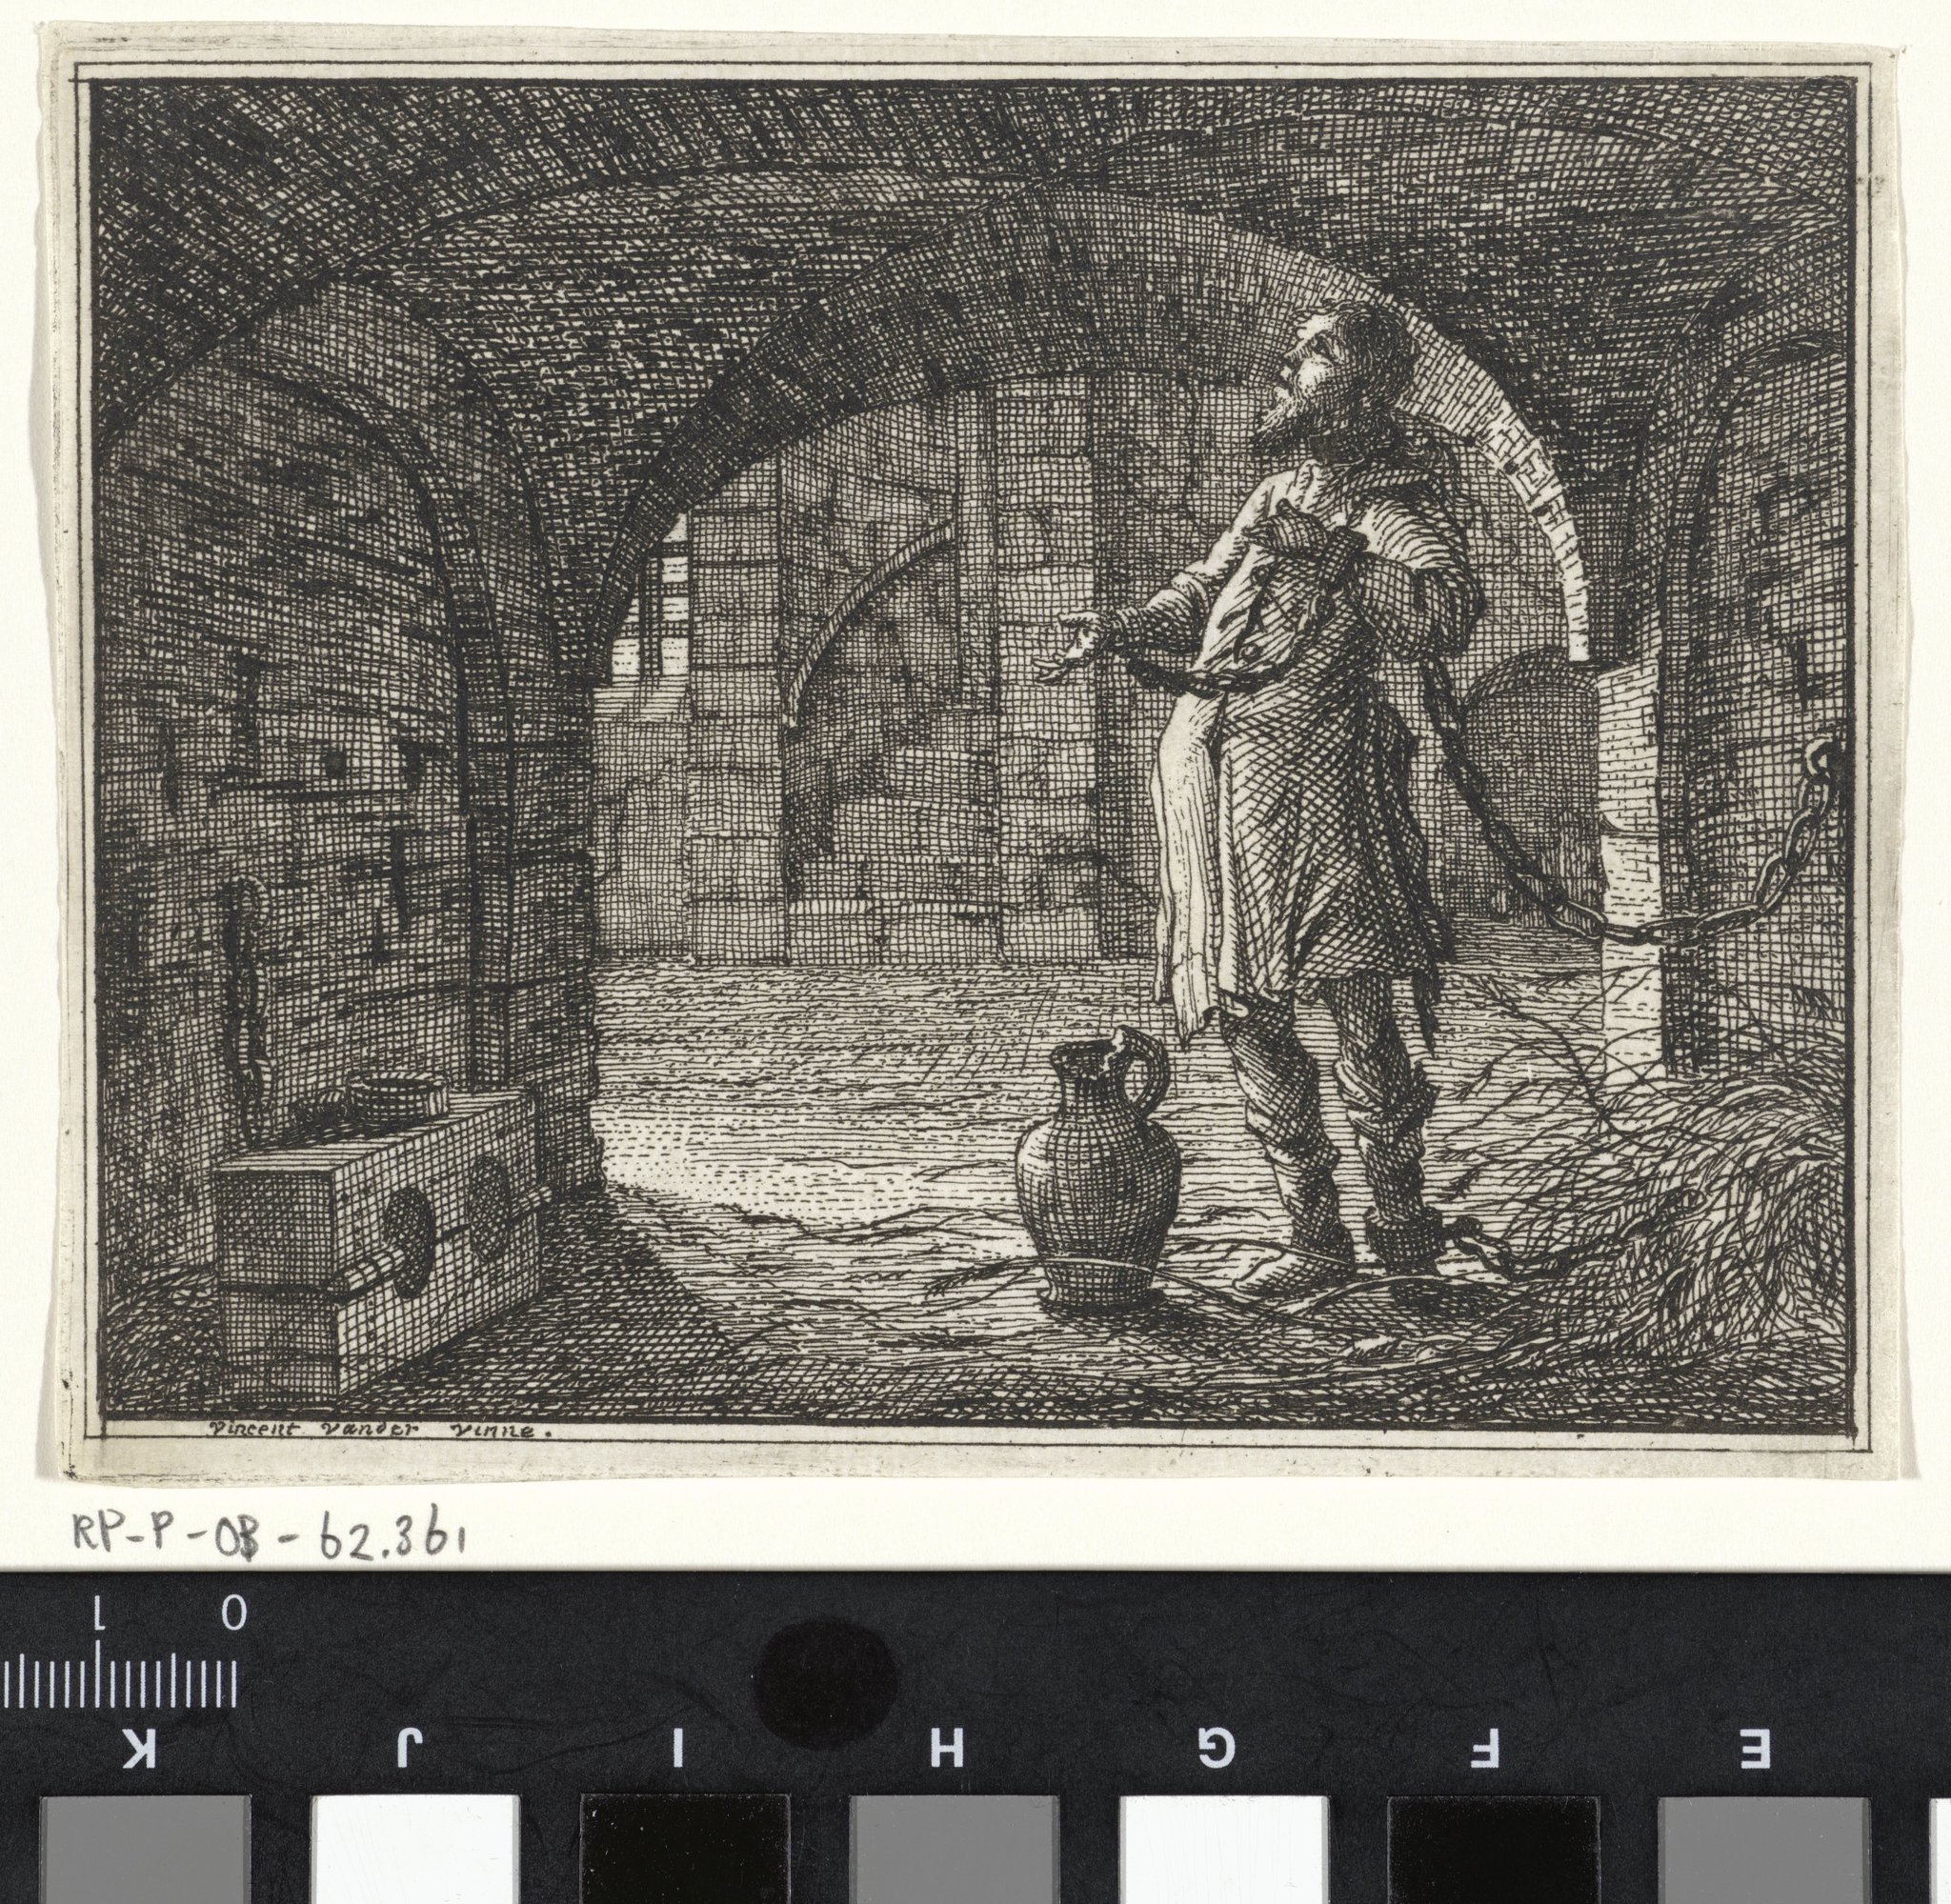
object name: print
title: Gevangene in een kerker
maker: vincent laurensz. van der vinne (ii)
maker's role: draughtsman, print maker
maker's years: 1686-1742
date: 1714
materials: paper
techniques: etching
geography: haarlem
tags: prison, jail, represented allegorically or symbolically, jar, jug (used as drinking-vessel), tools, aids, implements ~ crafts and industries: chain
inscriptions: collector's mark: Lugt 2228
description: Een man is vastgeketend aan de muur van een kerker met kettingen. Naast hem staat een kruik. Hij kijkt naar een raam op de achtergrond. Zinnebeeld op de ware vrijheid buiten het aardse bestaan.